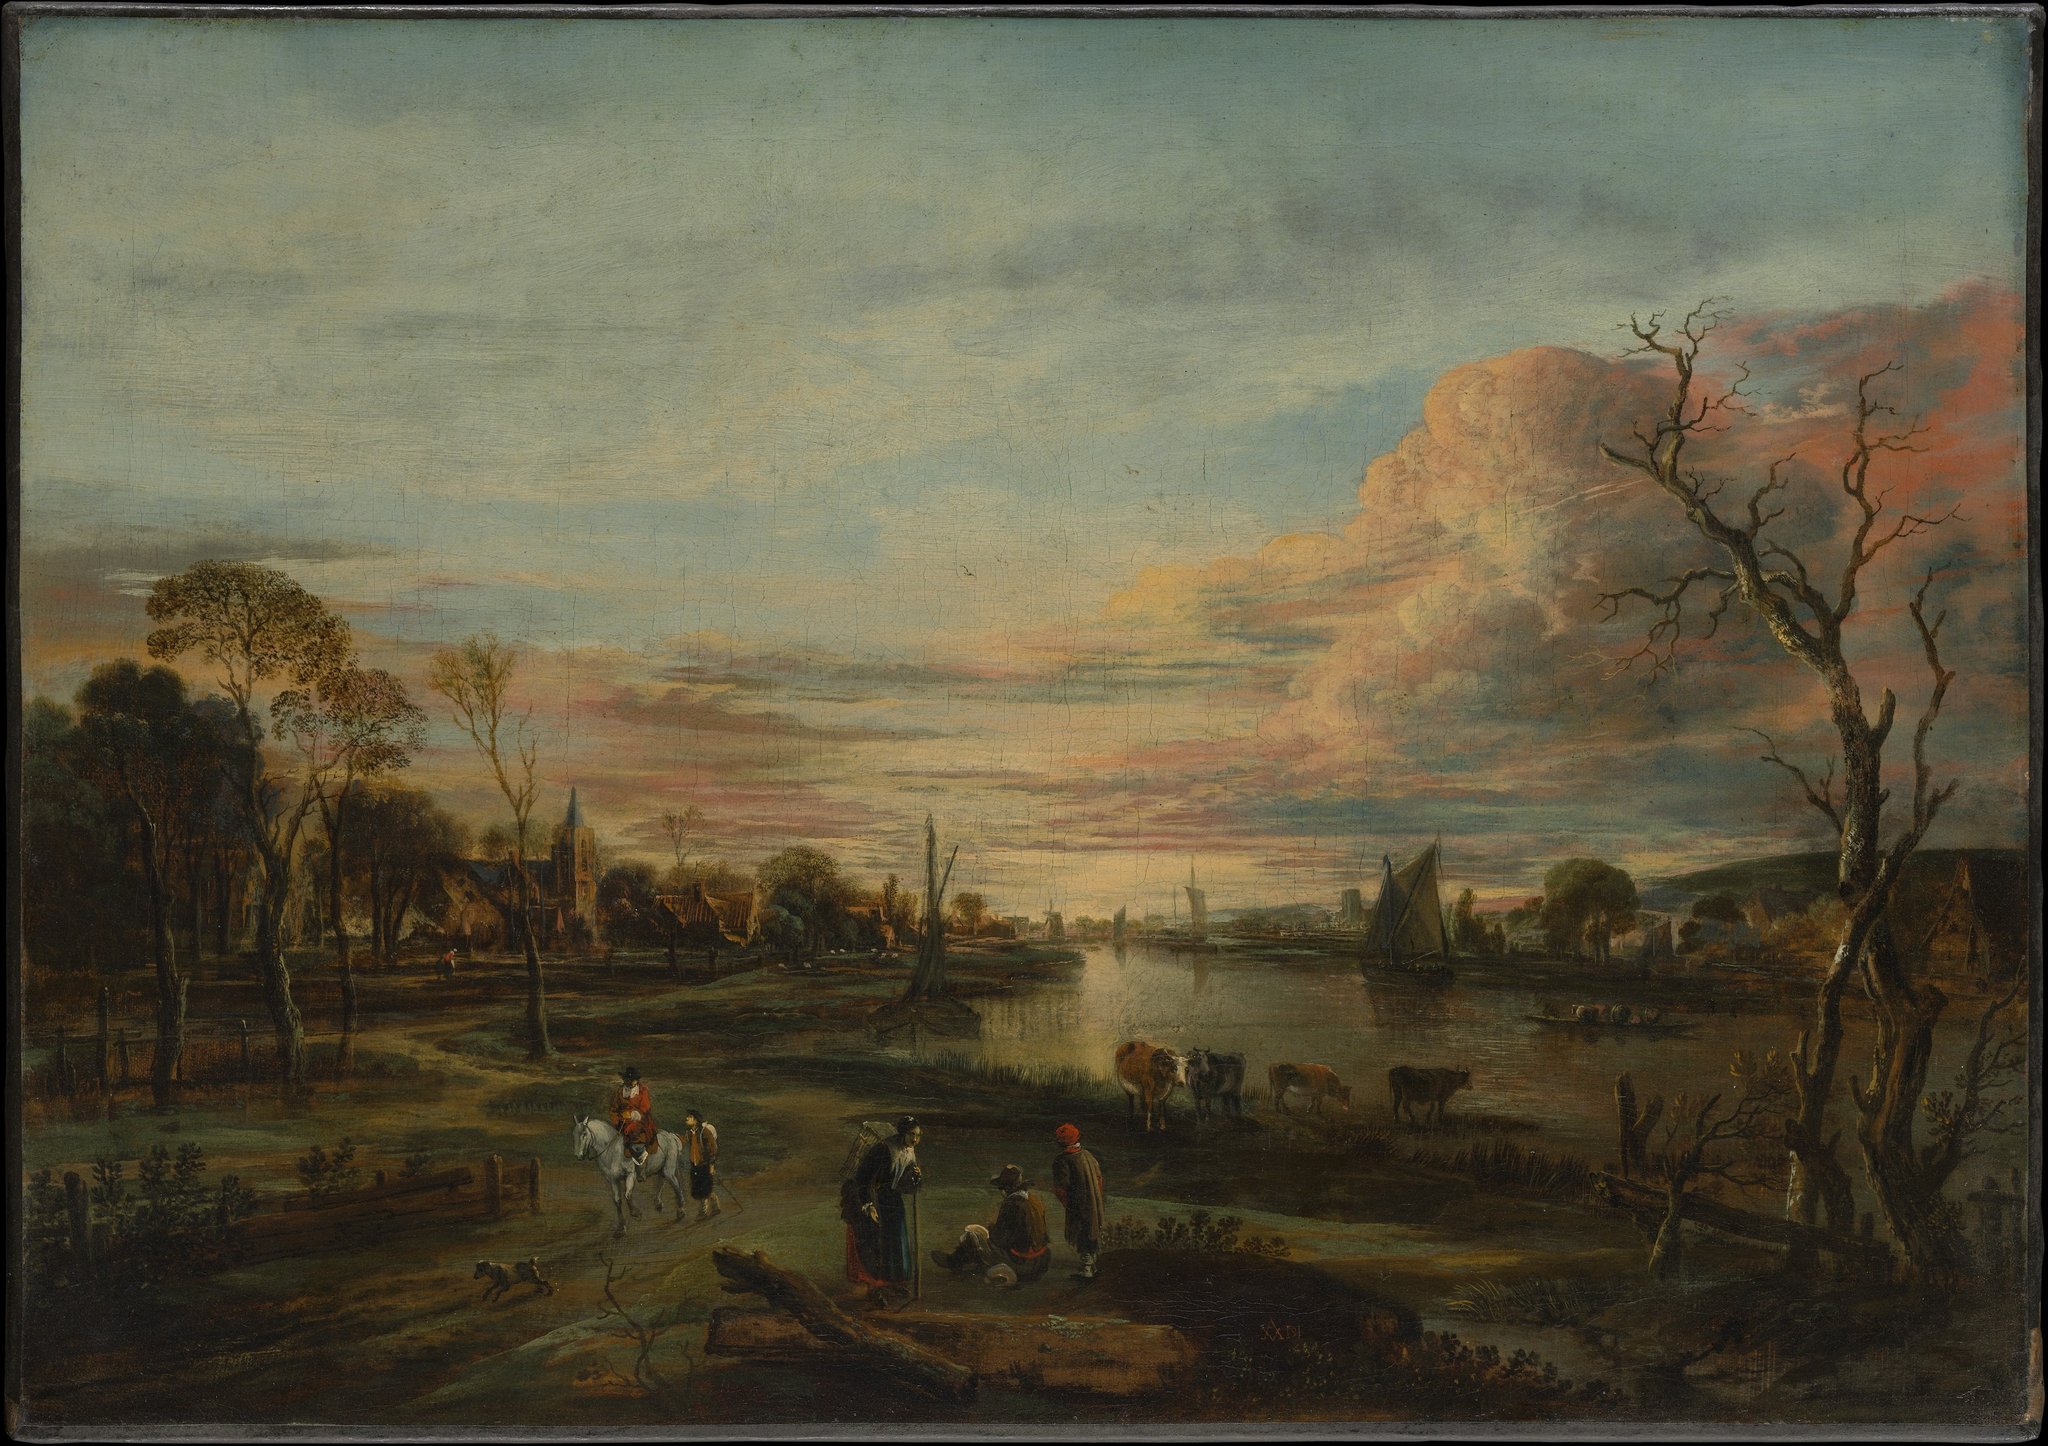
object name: painting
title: Landscape at Sunset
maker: aert van der neer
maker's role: artist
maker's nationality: dutch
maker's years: 1603-1677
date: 1650-1659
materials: canvas, oil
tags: cows,horses,rivers,landscapes